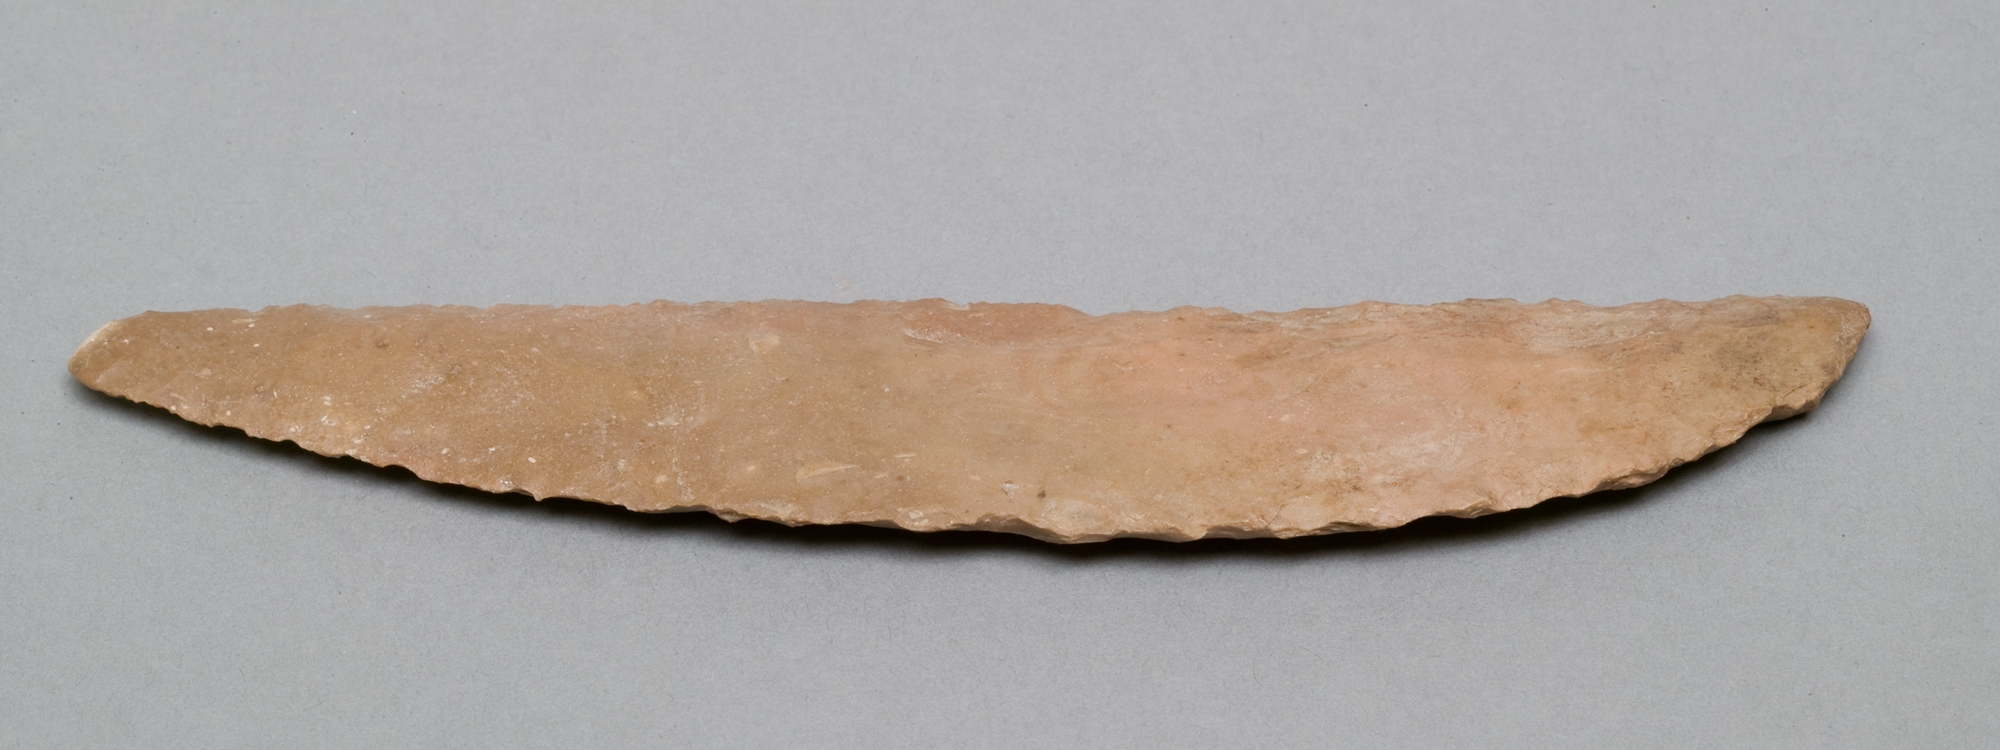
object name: knife, bifacial knife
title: Bifacial Knife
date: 1981-1640 BCE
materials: stone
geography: egypt